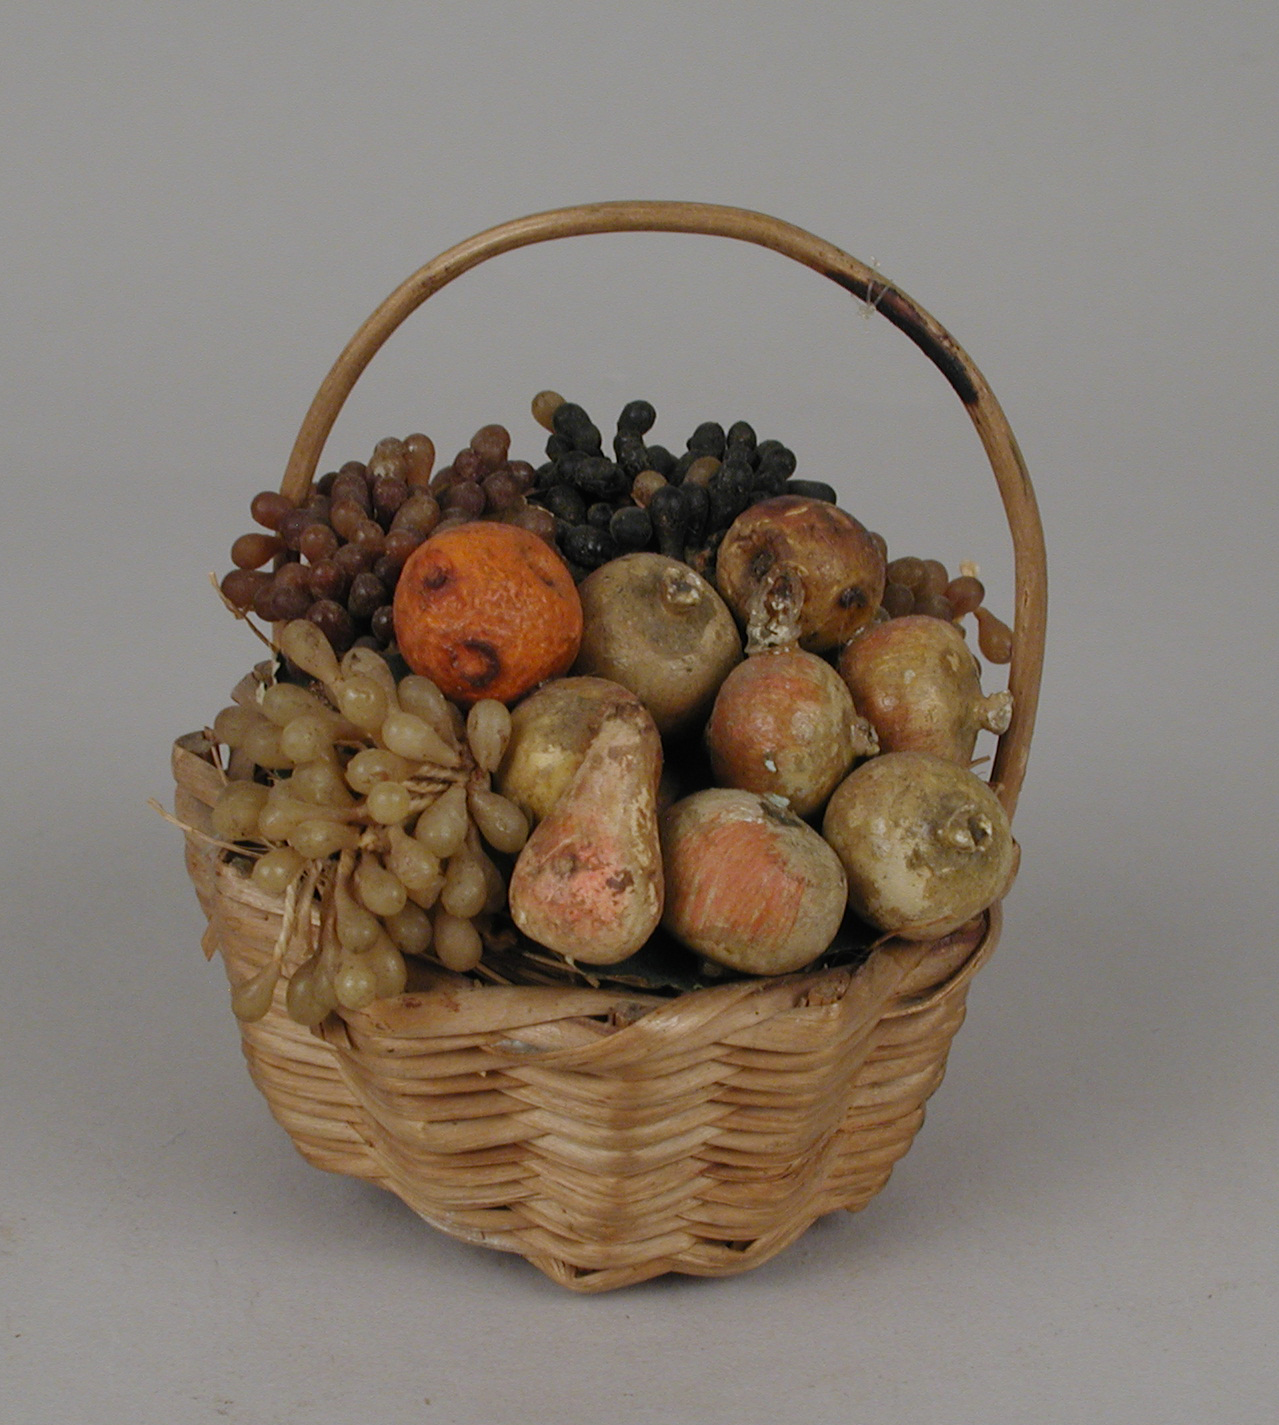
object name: crèche accessory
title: Basket of fruit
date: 1701-1800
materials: wax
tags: fruit